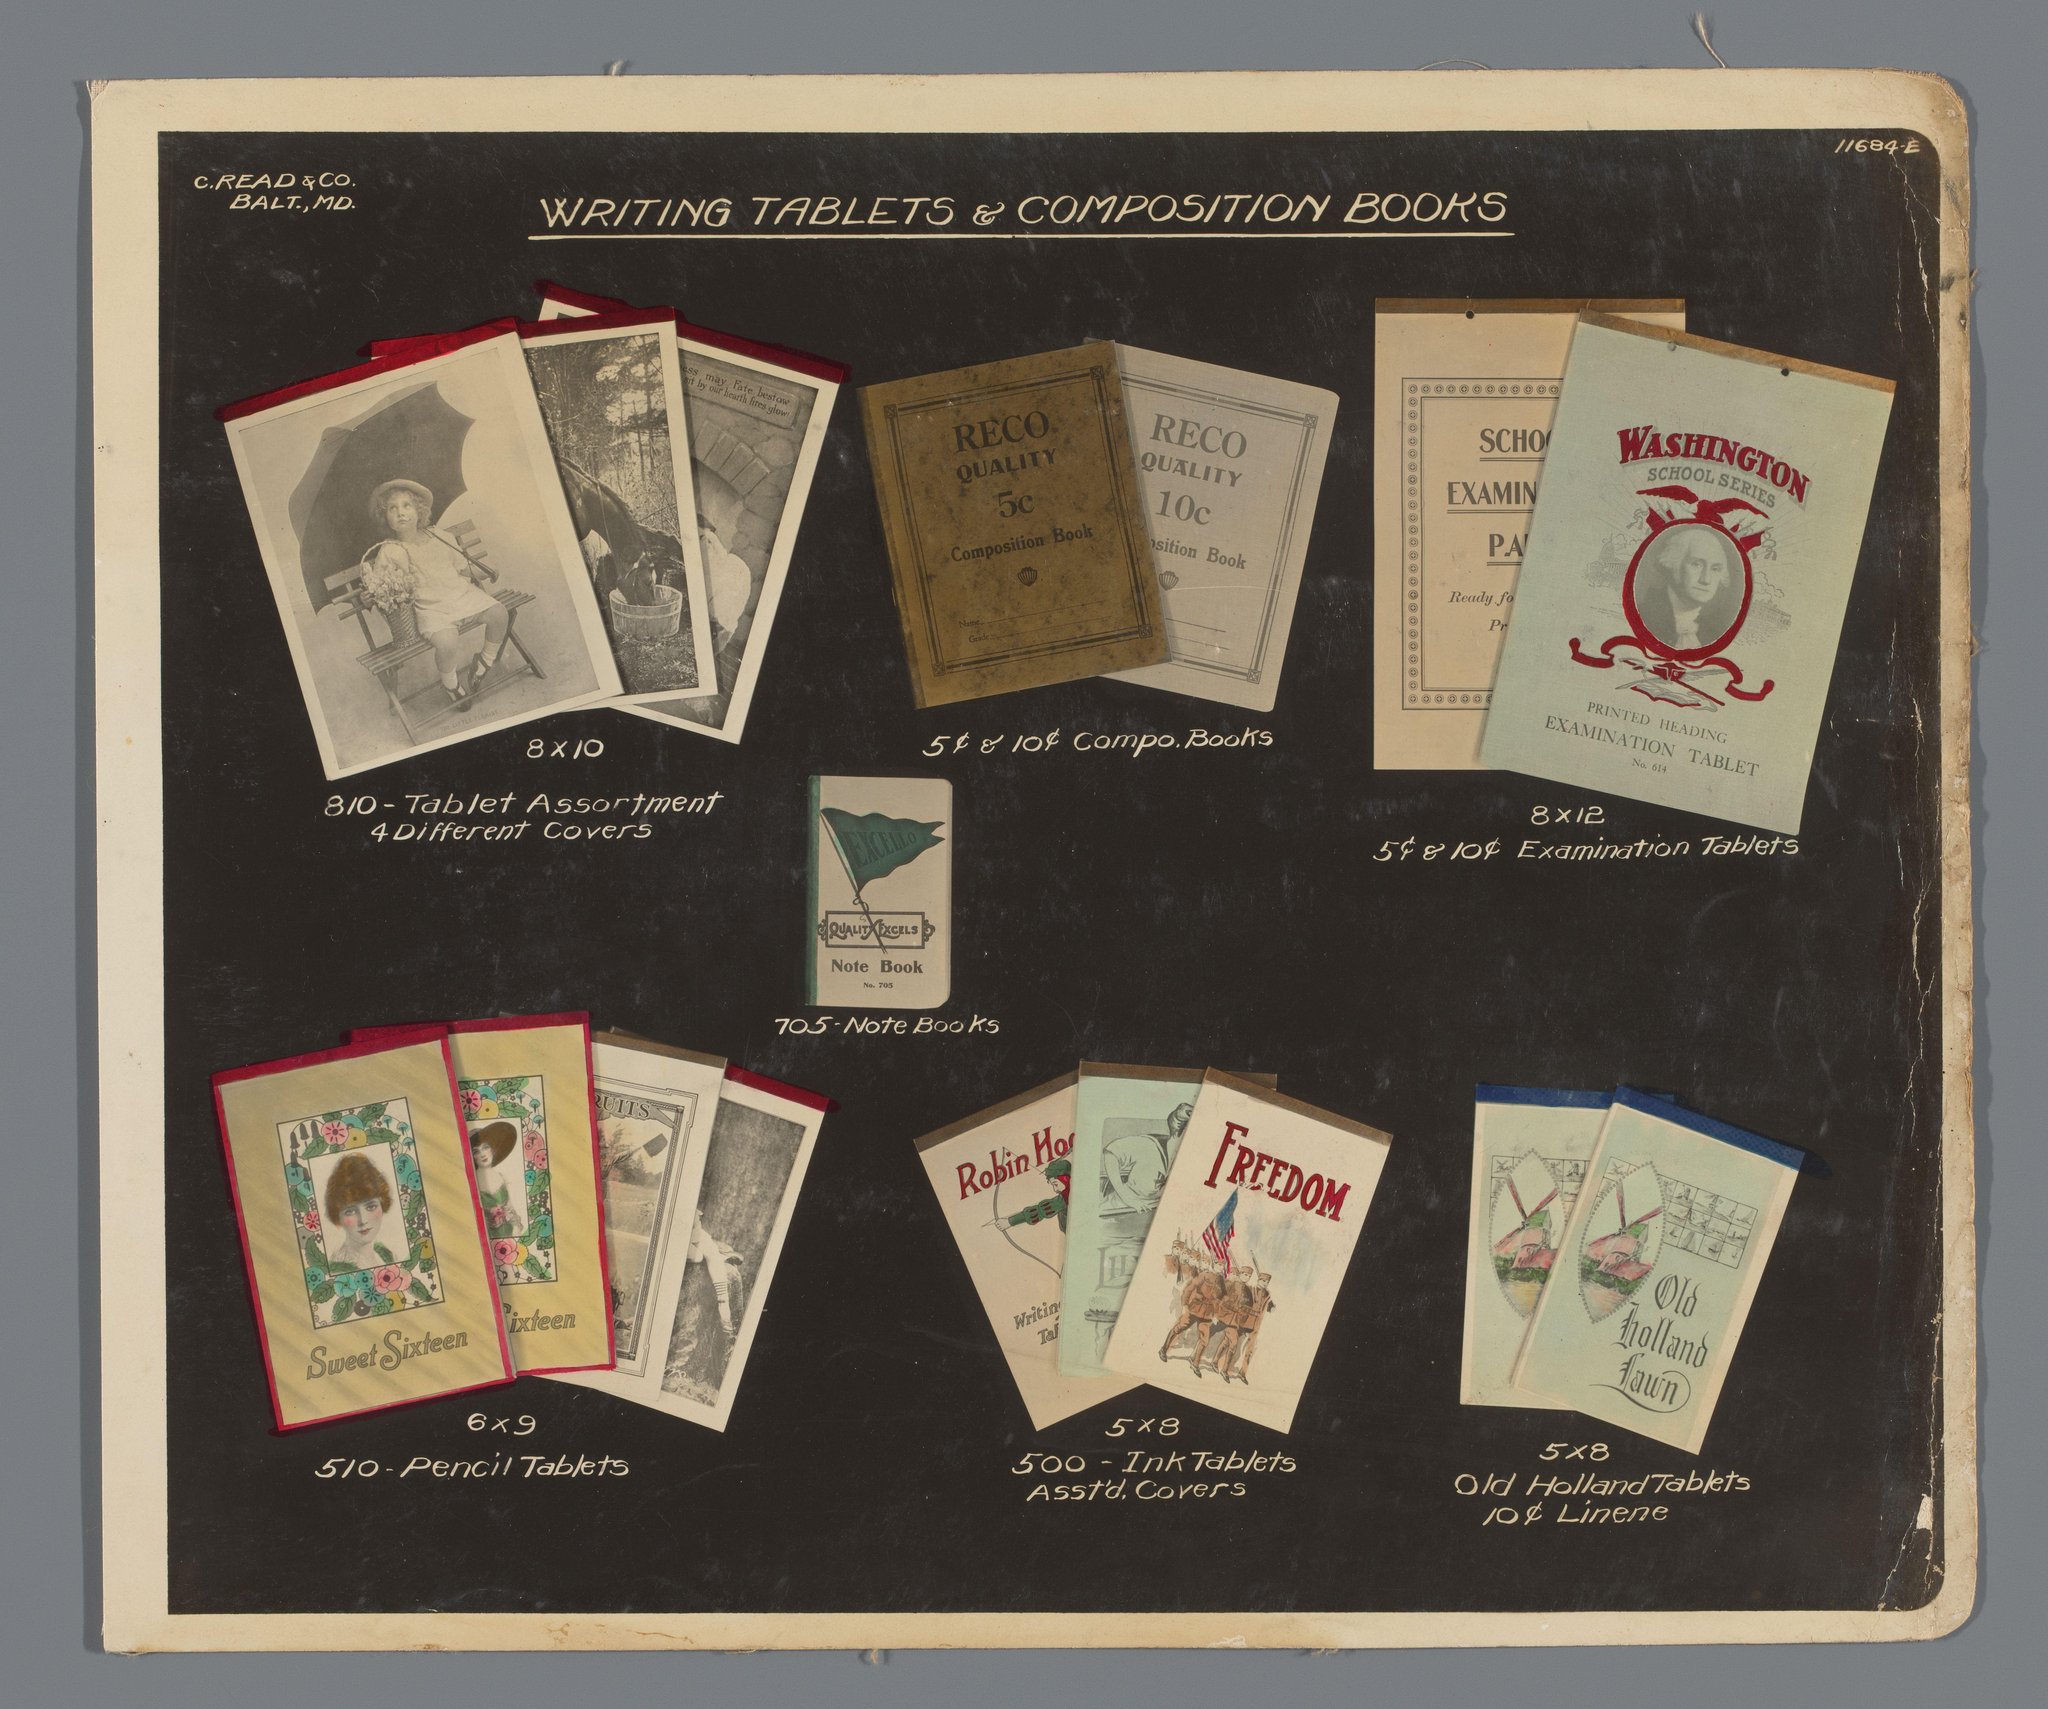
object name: photograph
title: Reclamefoto met serviezen en keukengerei van de firma C. Read & Co., Baltimore, Maryland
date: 1920-1930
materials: paper, textile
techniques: photography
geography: united states